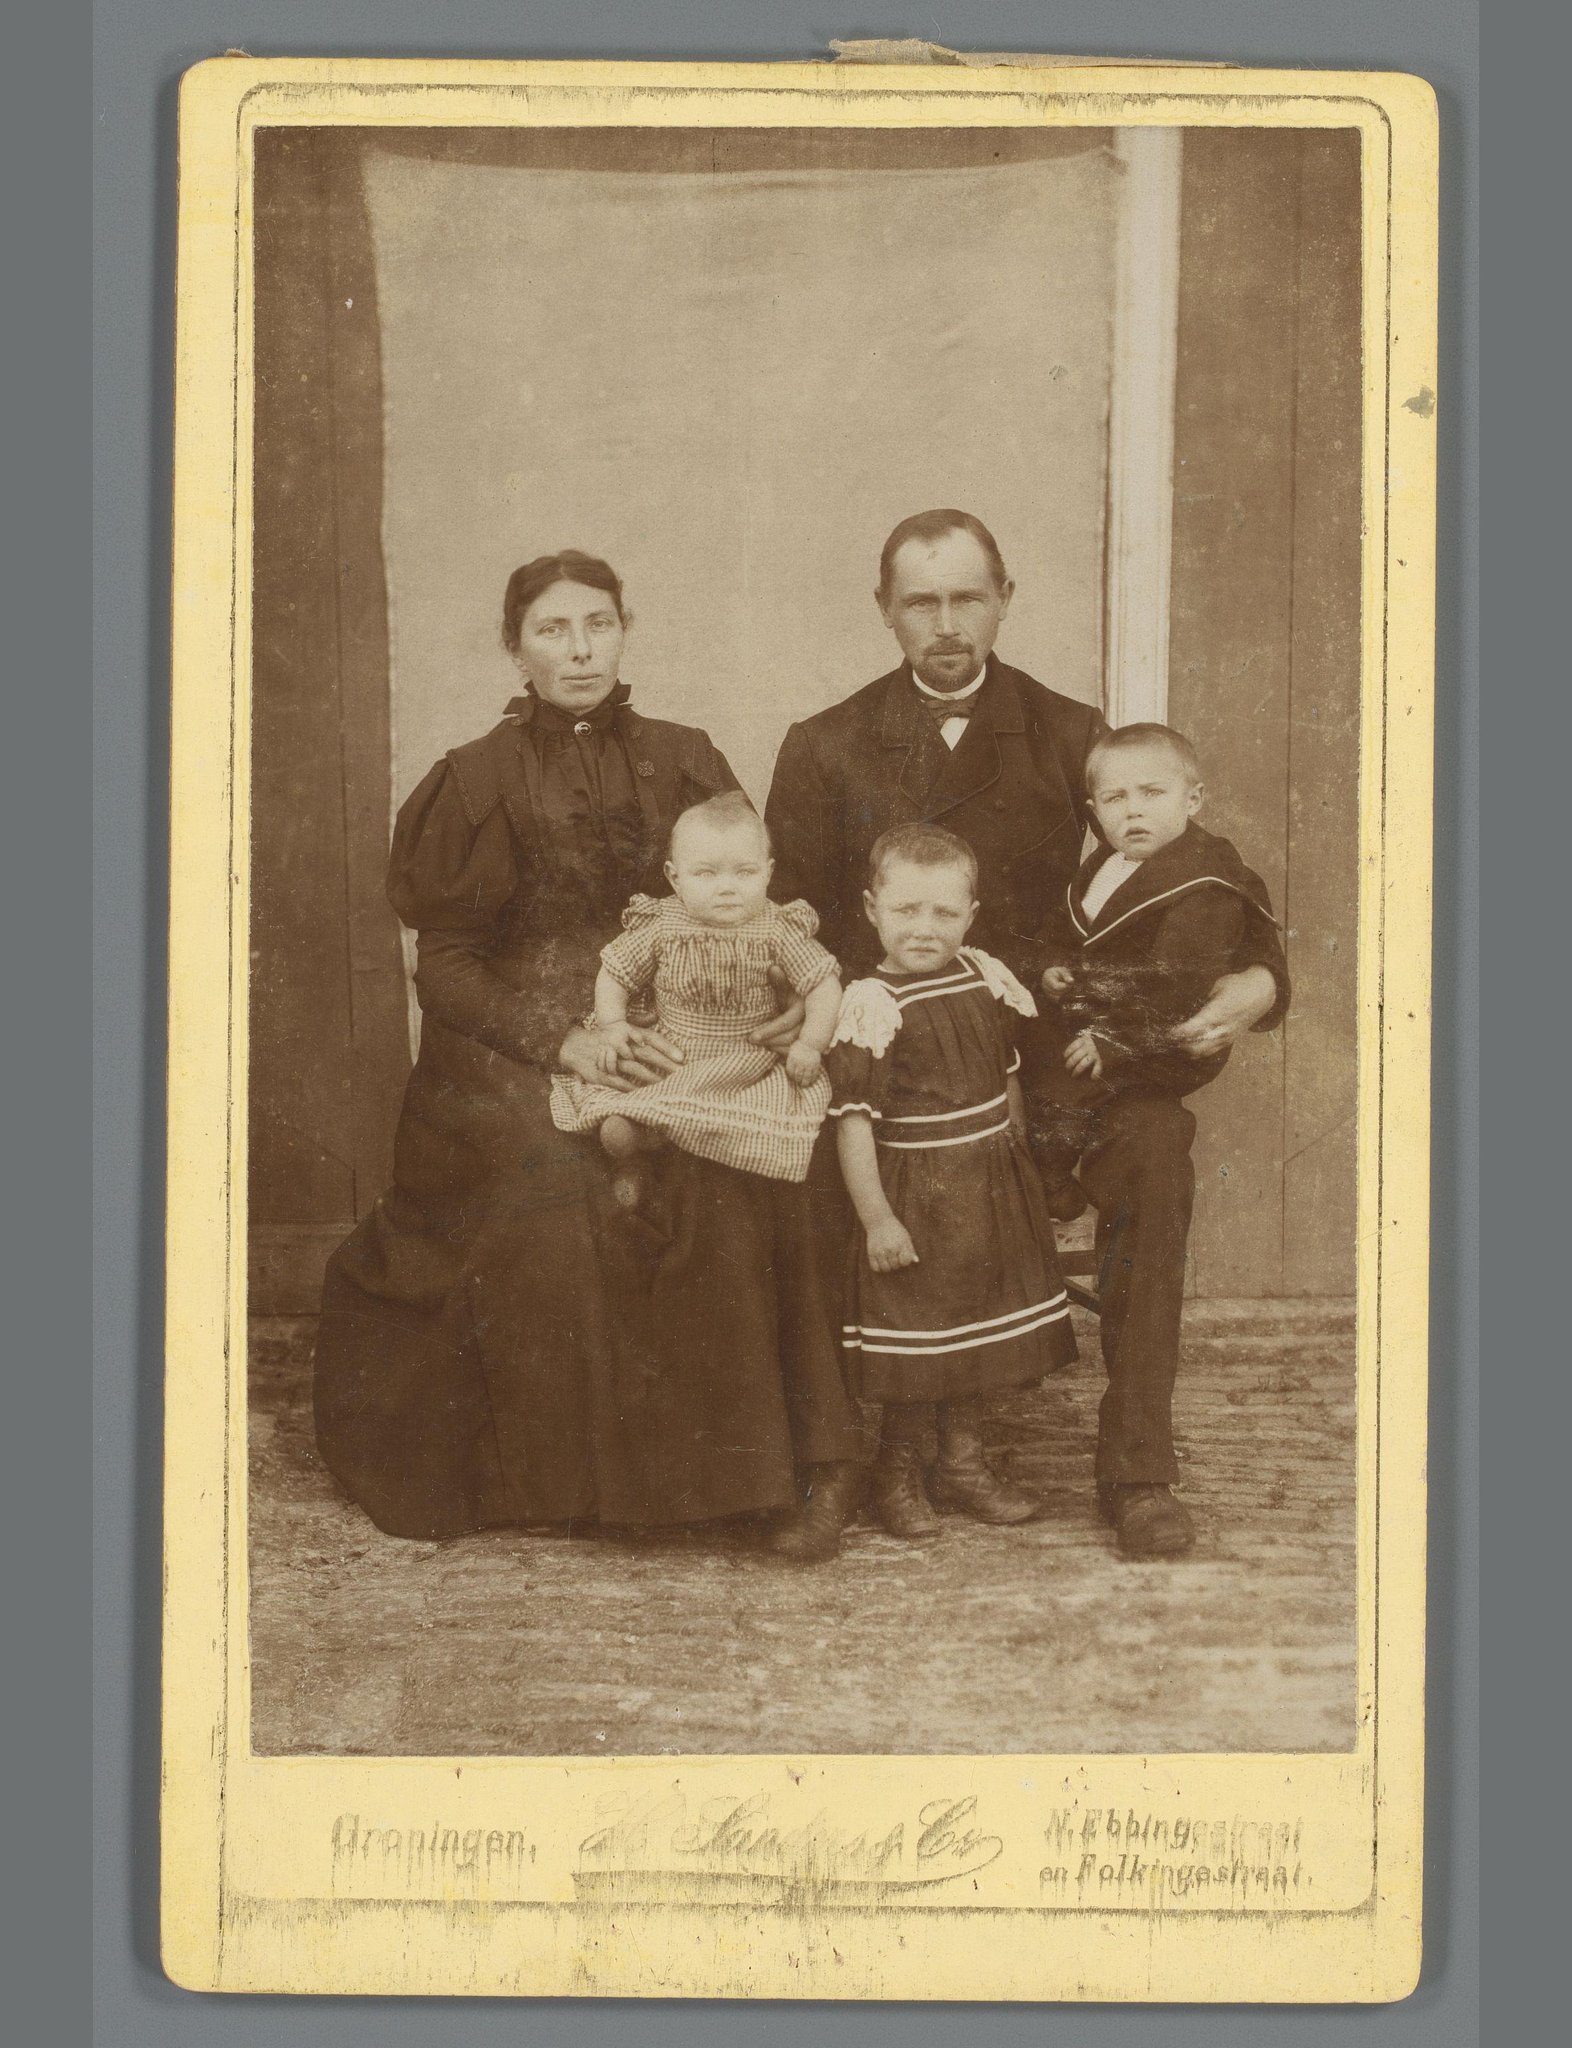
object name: cabinet photograph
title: Portret van een onbekend gezin met drie kinderen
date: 1893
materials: paper, cardboard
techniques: gelatin silver print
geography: groningen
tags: family group, especially parents with their child(ren), historical persons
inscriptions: inscription: ‘+/- 1893’, inscription: ‘PHOTOGRAPHIE/ H. Sanders & Co/ N. Ebbingestraat 47./ Folkingestraat 295a/ GRONINGEN./ De plaat blijft ter nabestelling bewaard.’